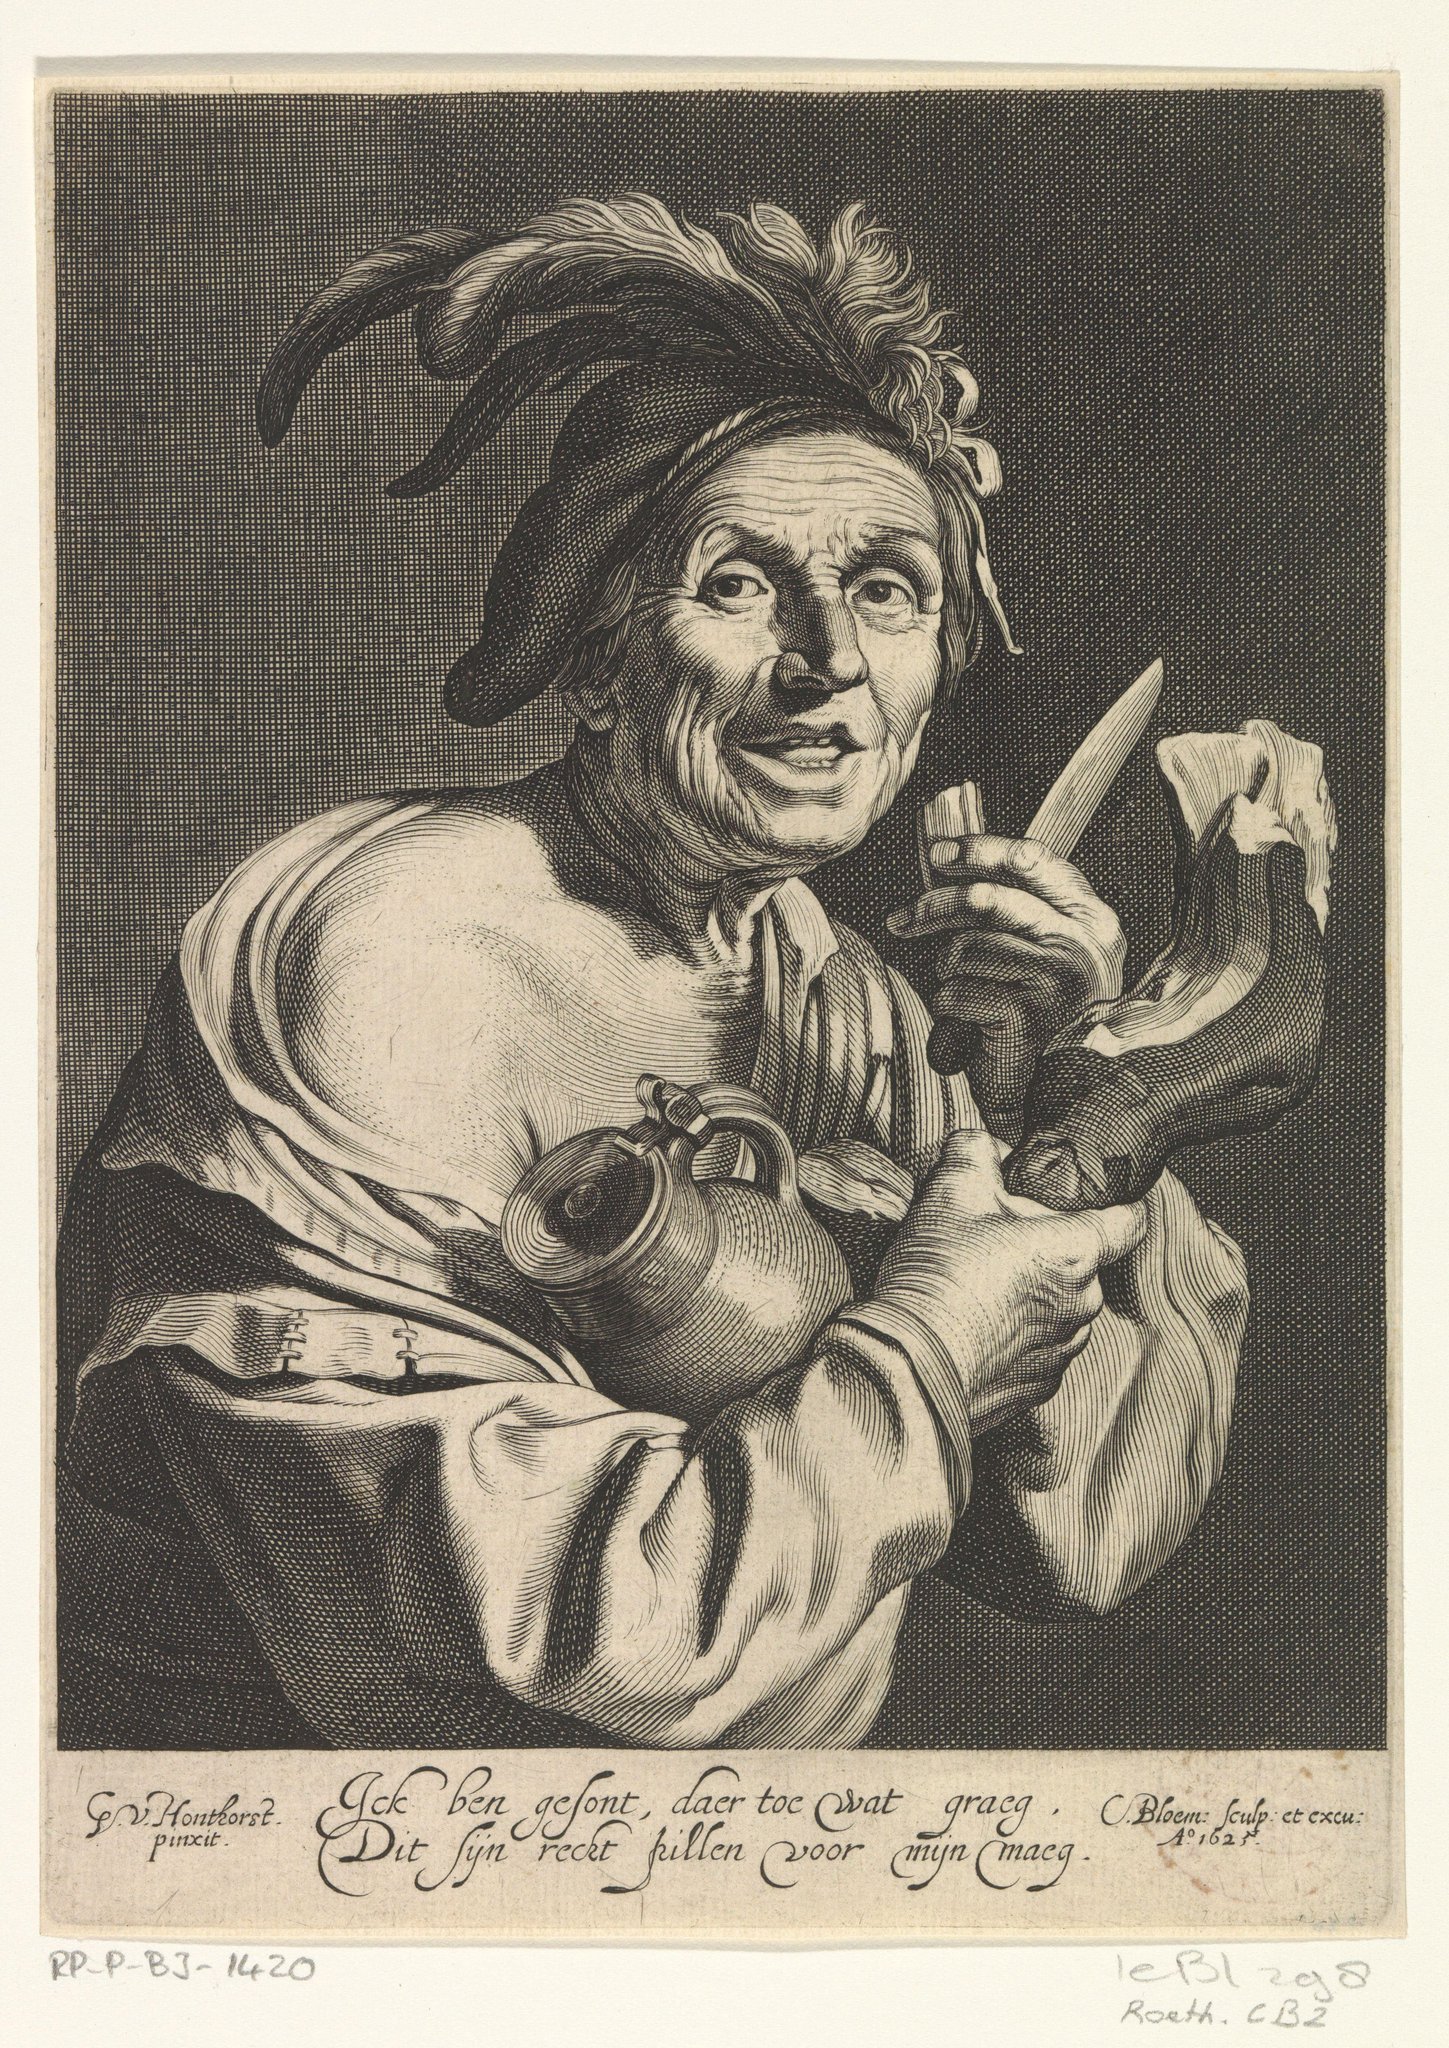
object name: print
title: Man eet ham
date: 1625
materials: paper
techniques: engraving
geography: utrecht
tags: ham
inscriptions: collector's mark: Lugt 240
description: Een man heeft in de rechterarm een kruik en een aangesneden ham. Met zijn linkerhand brengt hij een stuk ham naar zijn mond. Met tweeregelig Nederlands onderschrift.